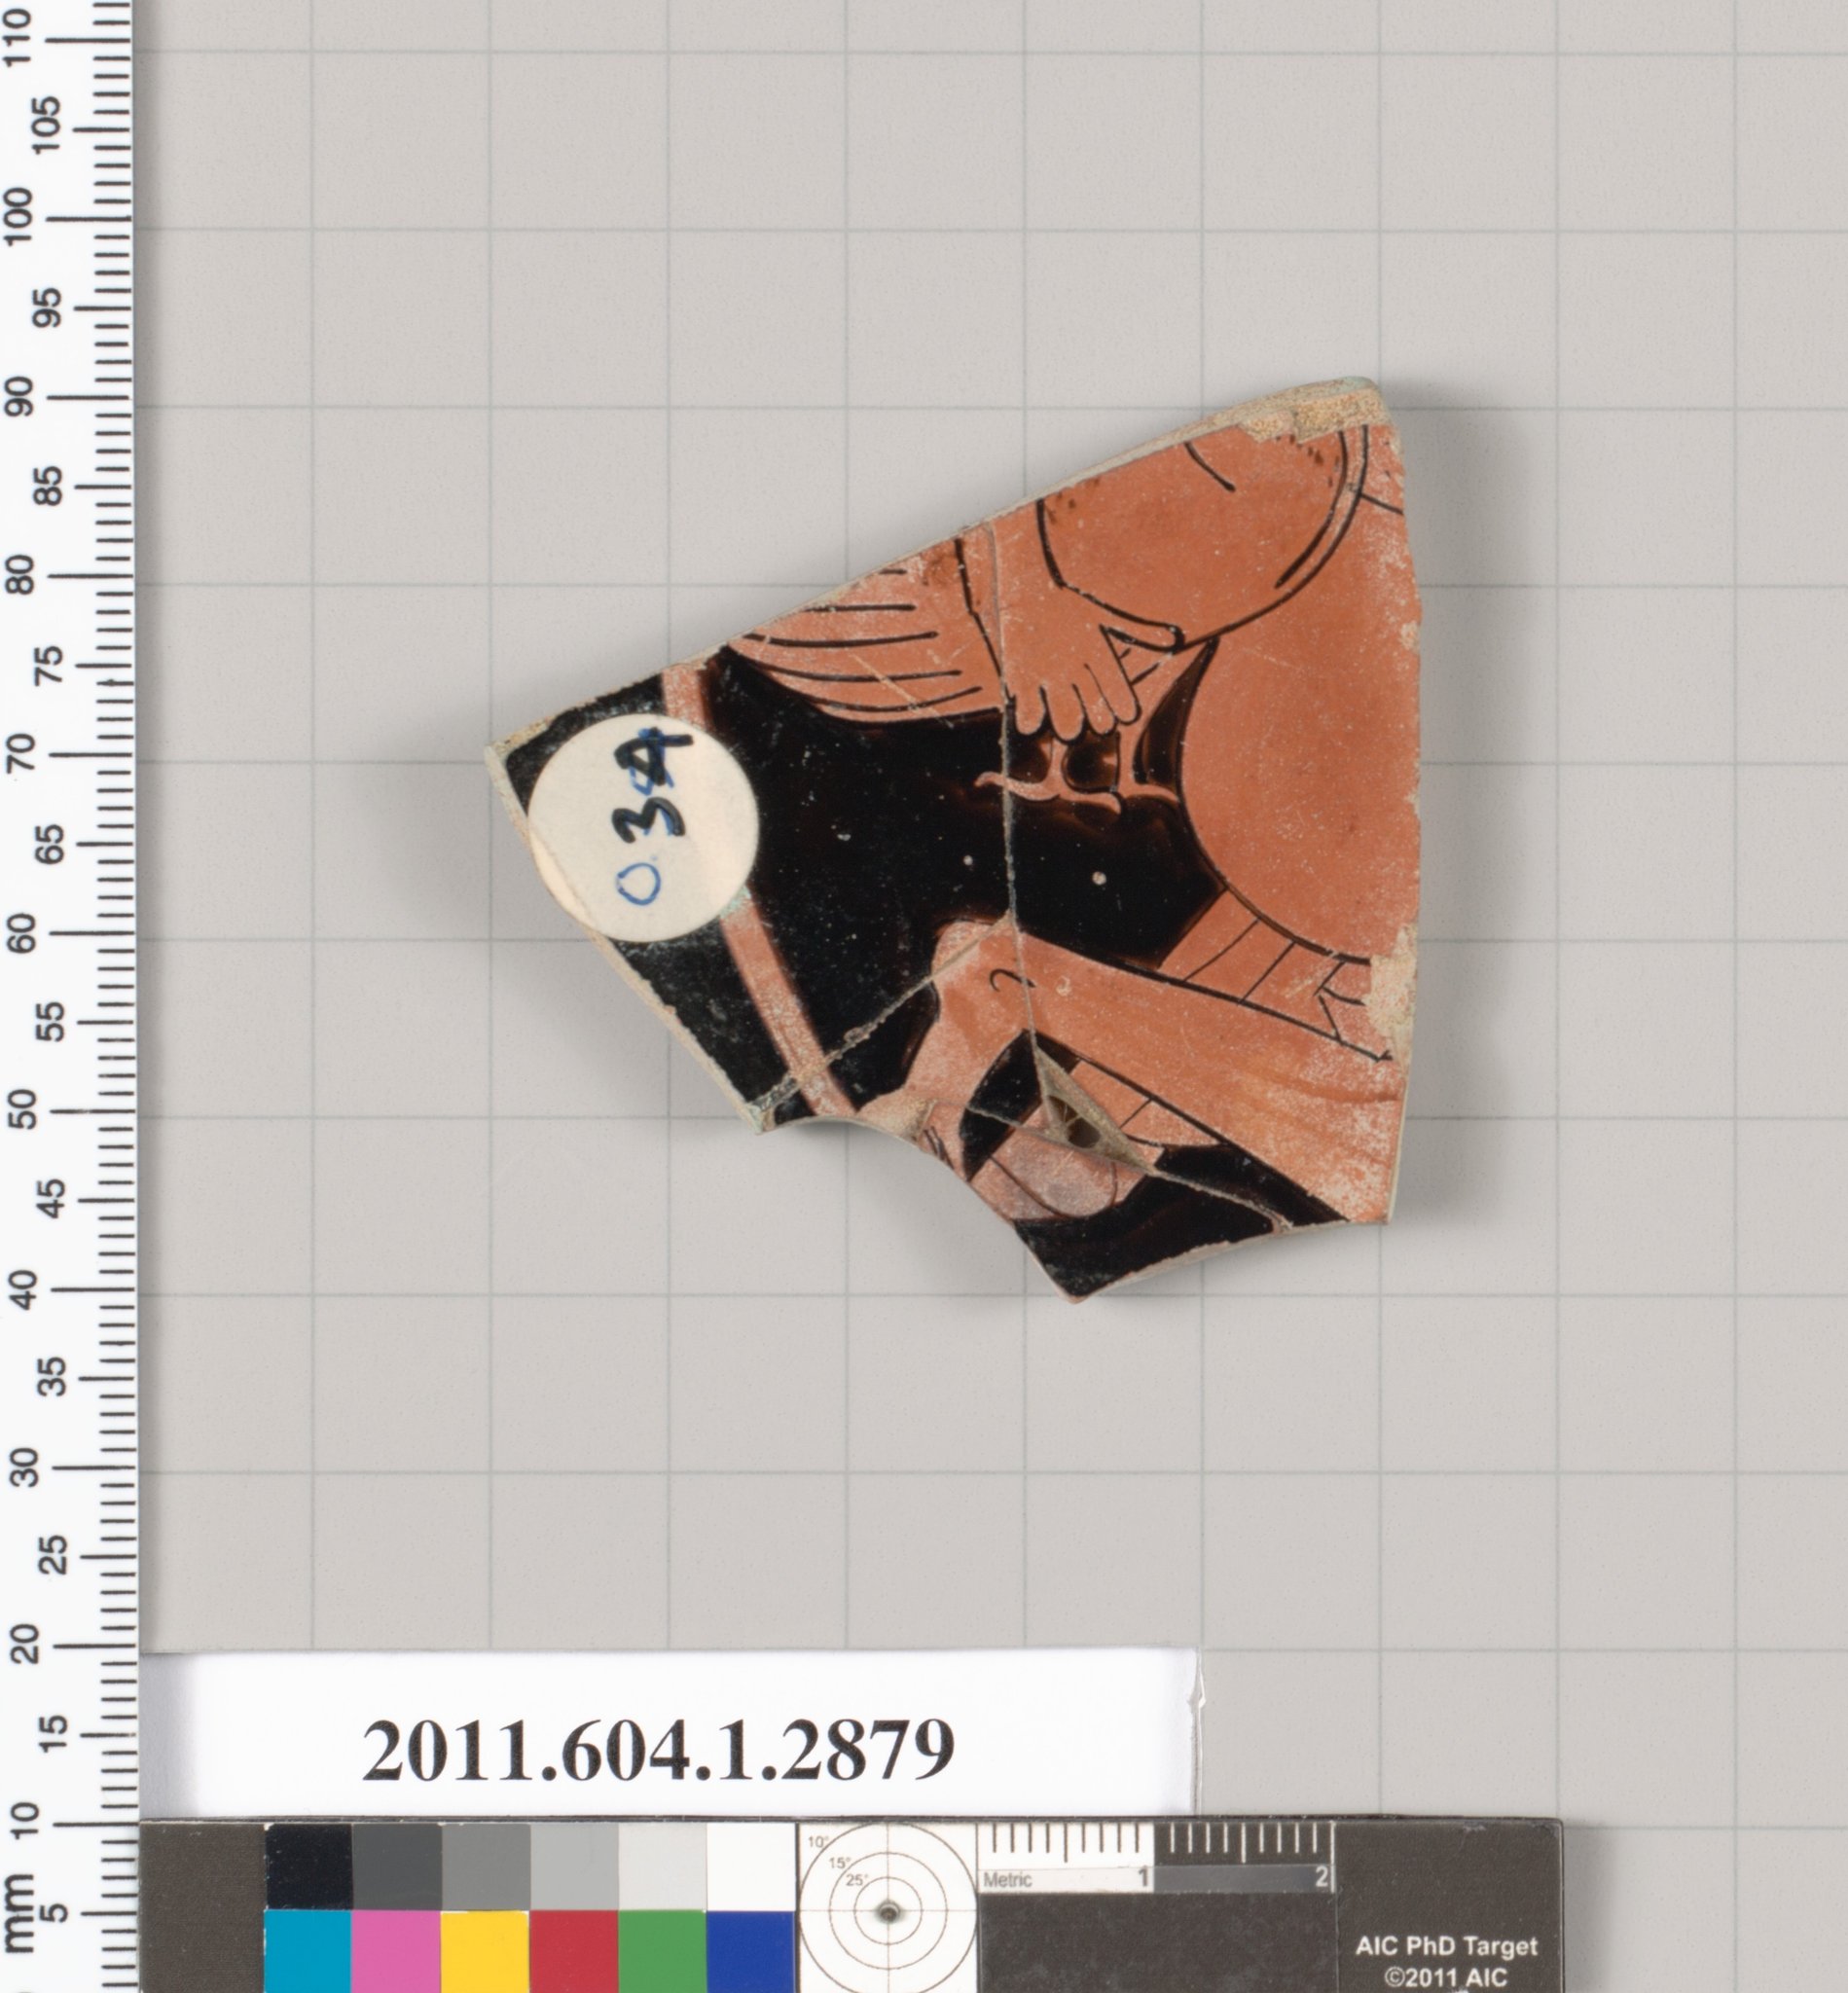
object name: kylix fragment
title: Terracotta fragment of a kylix (drinking cup)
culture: greek, attic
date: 500-490 BCE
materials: terracotta